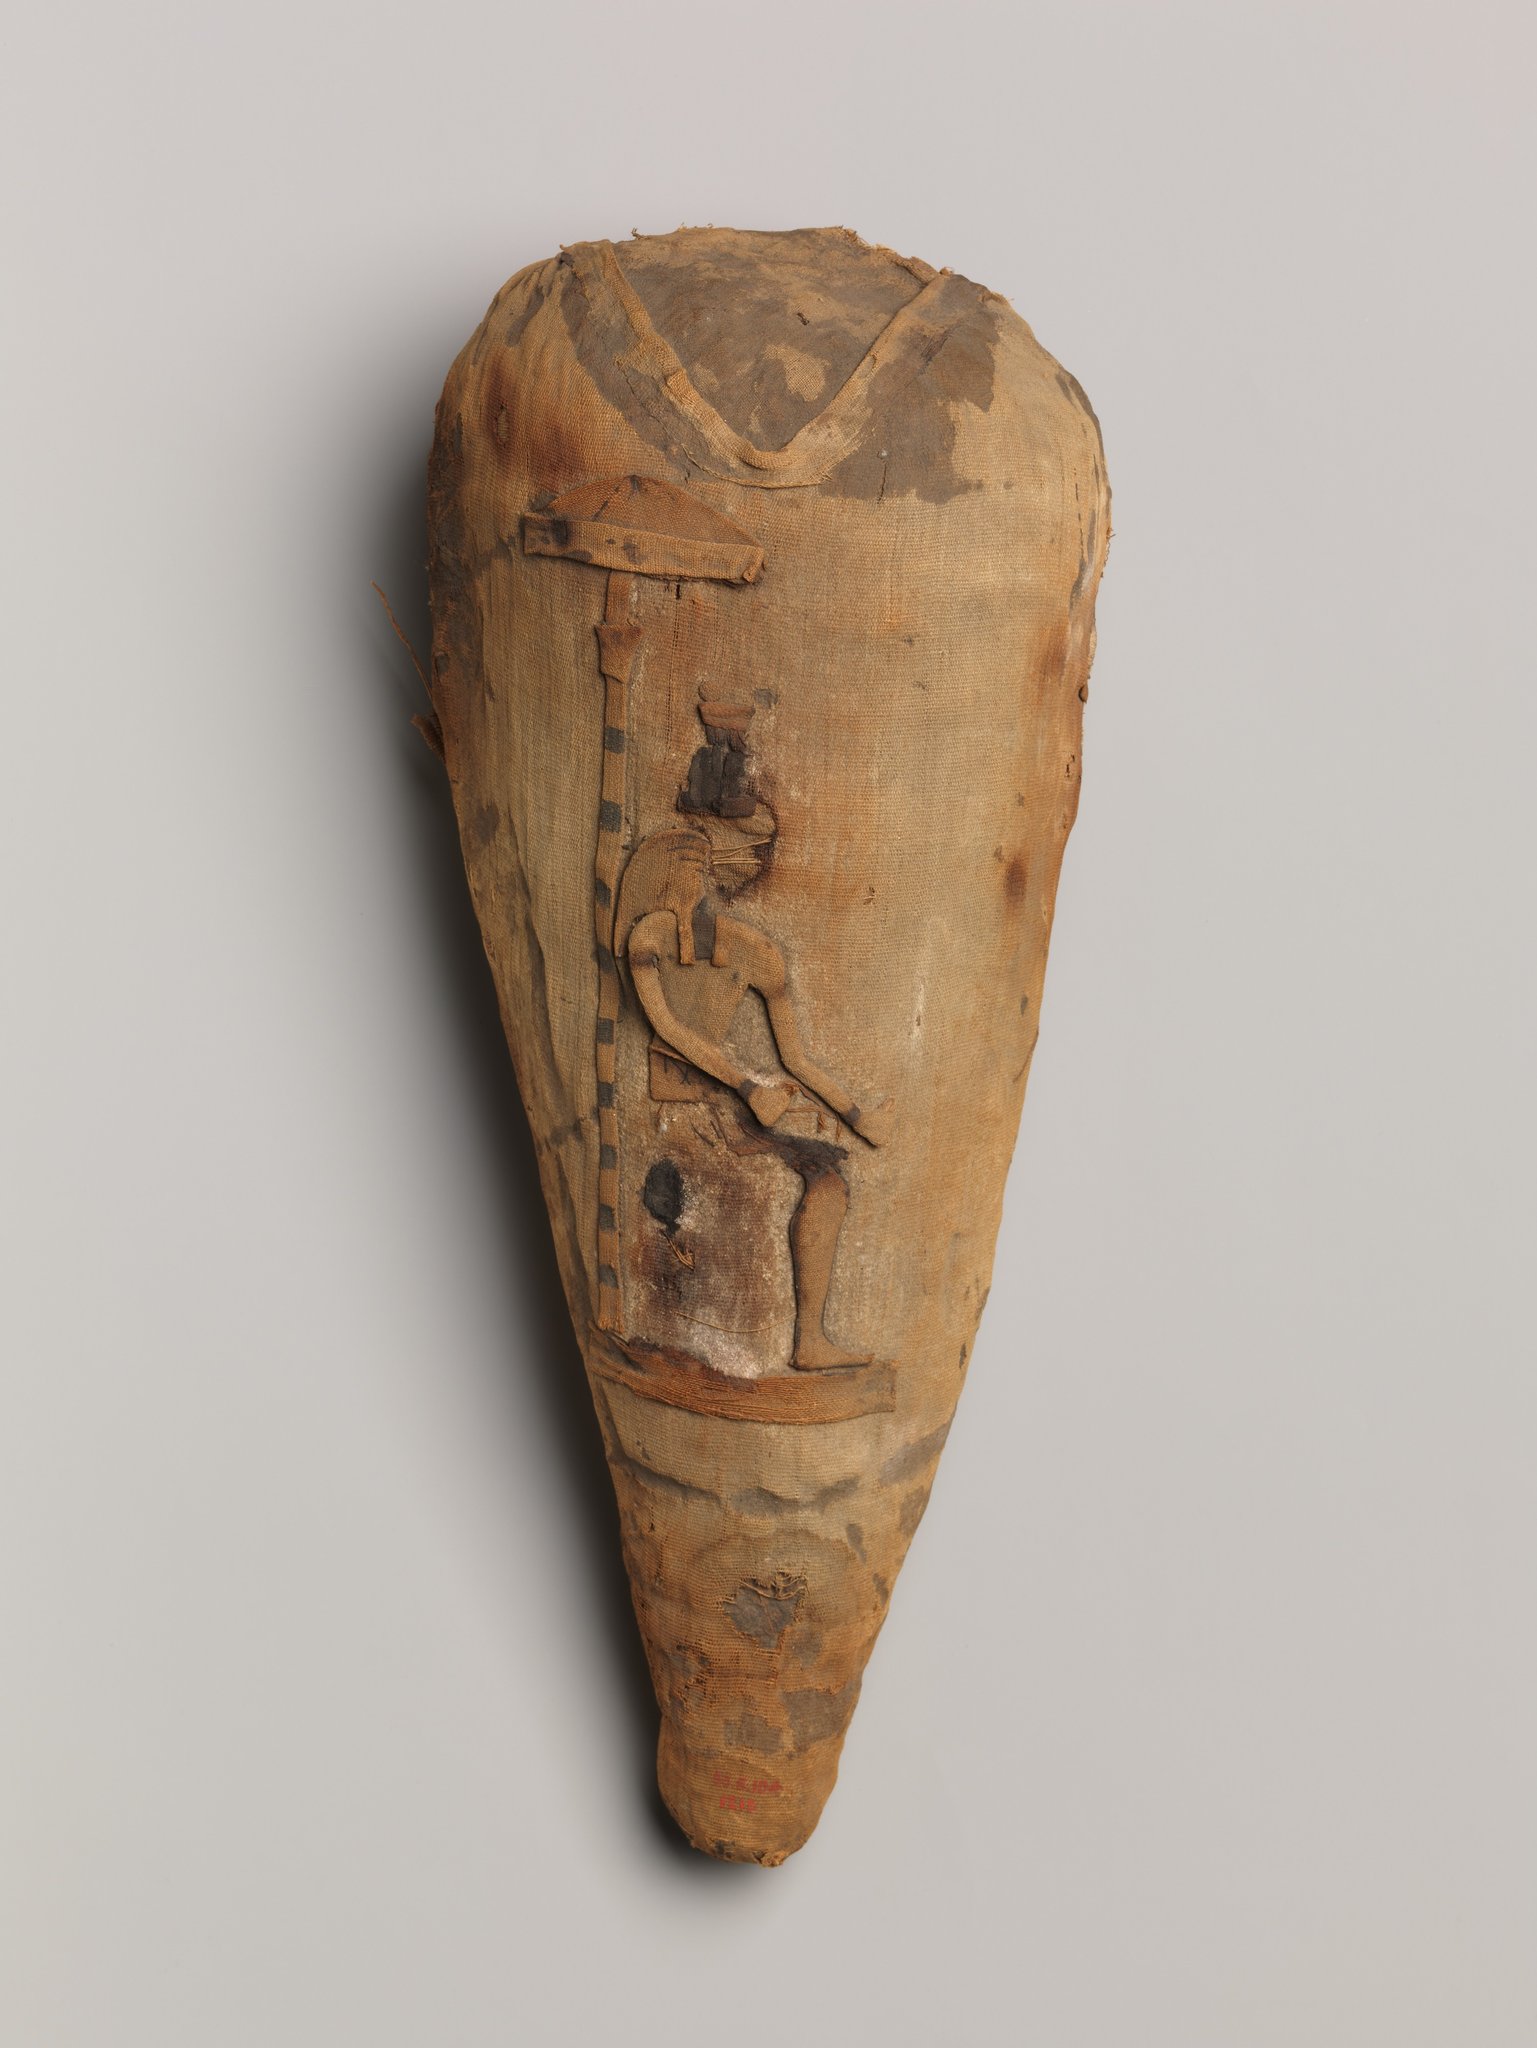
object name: mummy, animal, ibis headed god appliqué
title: Package of disorganized animal remains adorned with a seated Thoth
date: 332-330 BCE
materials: linen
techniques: dyeing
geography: egypt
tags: mummies